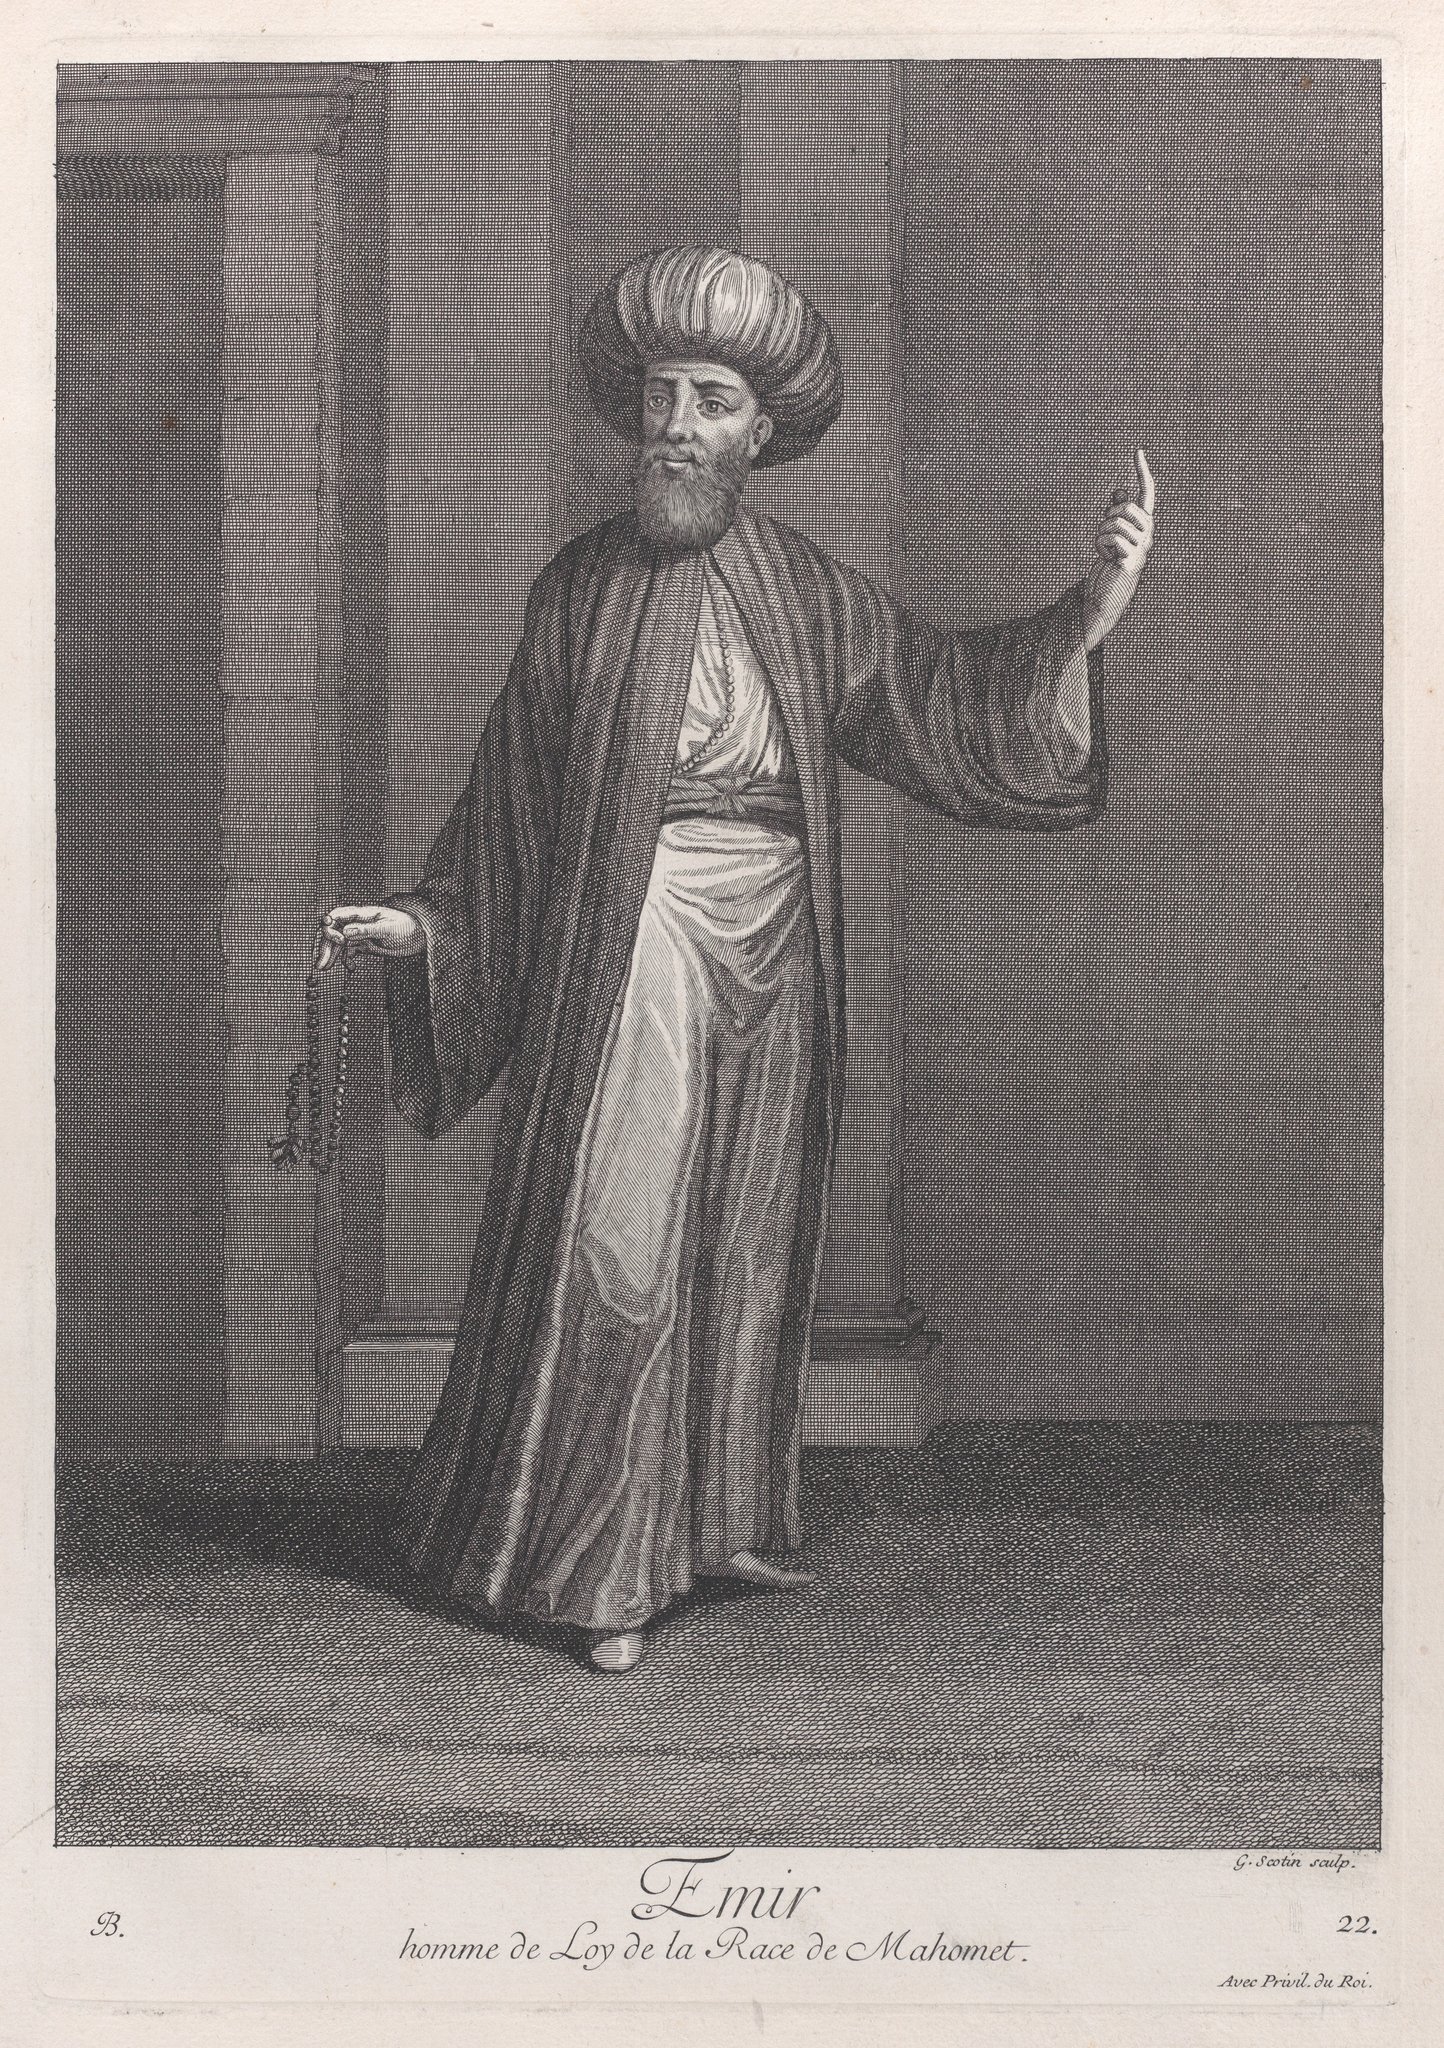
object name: print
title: Emir, homme de Loy de la Race de Mahomet, plate 22 from "Recueil de cent estampes représentent differentes nations du Levant"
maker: jean baptiste vanmour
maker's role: artist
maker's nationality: french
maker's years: 1671-1737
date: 1714-1715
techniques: engraving, etching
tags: men